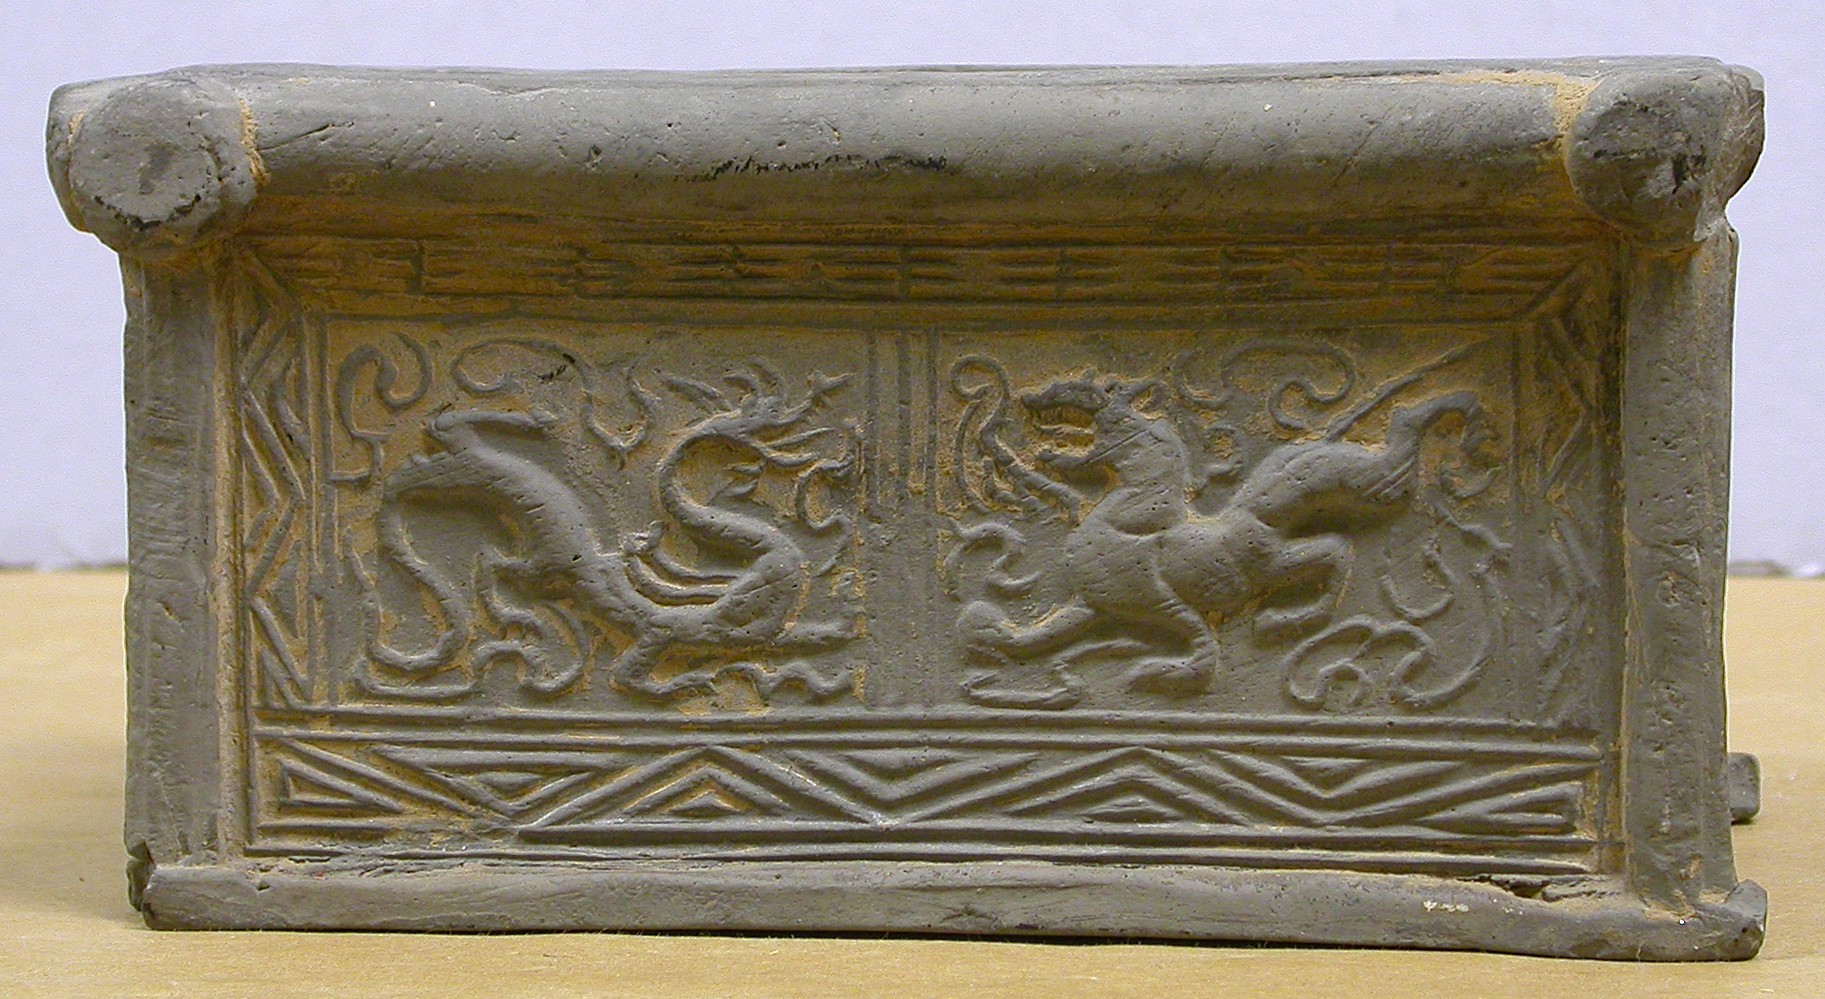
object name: model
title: Model of a Wellhead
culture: chinese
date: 206 BCE-220 CE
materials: pottery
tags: dragons